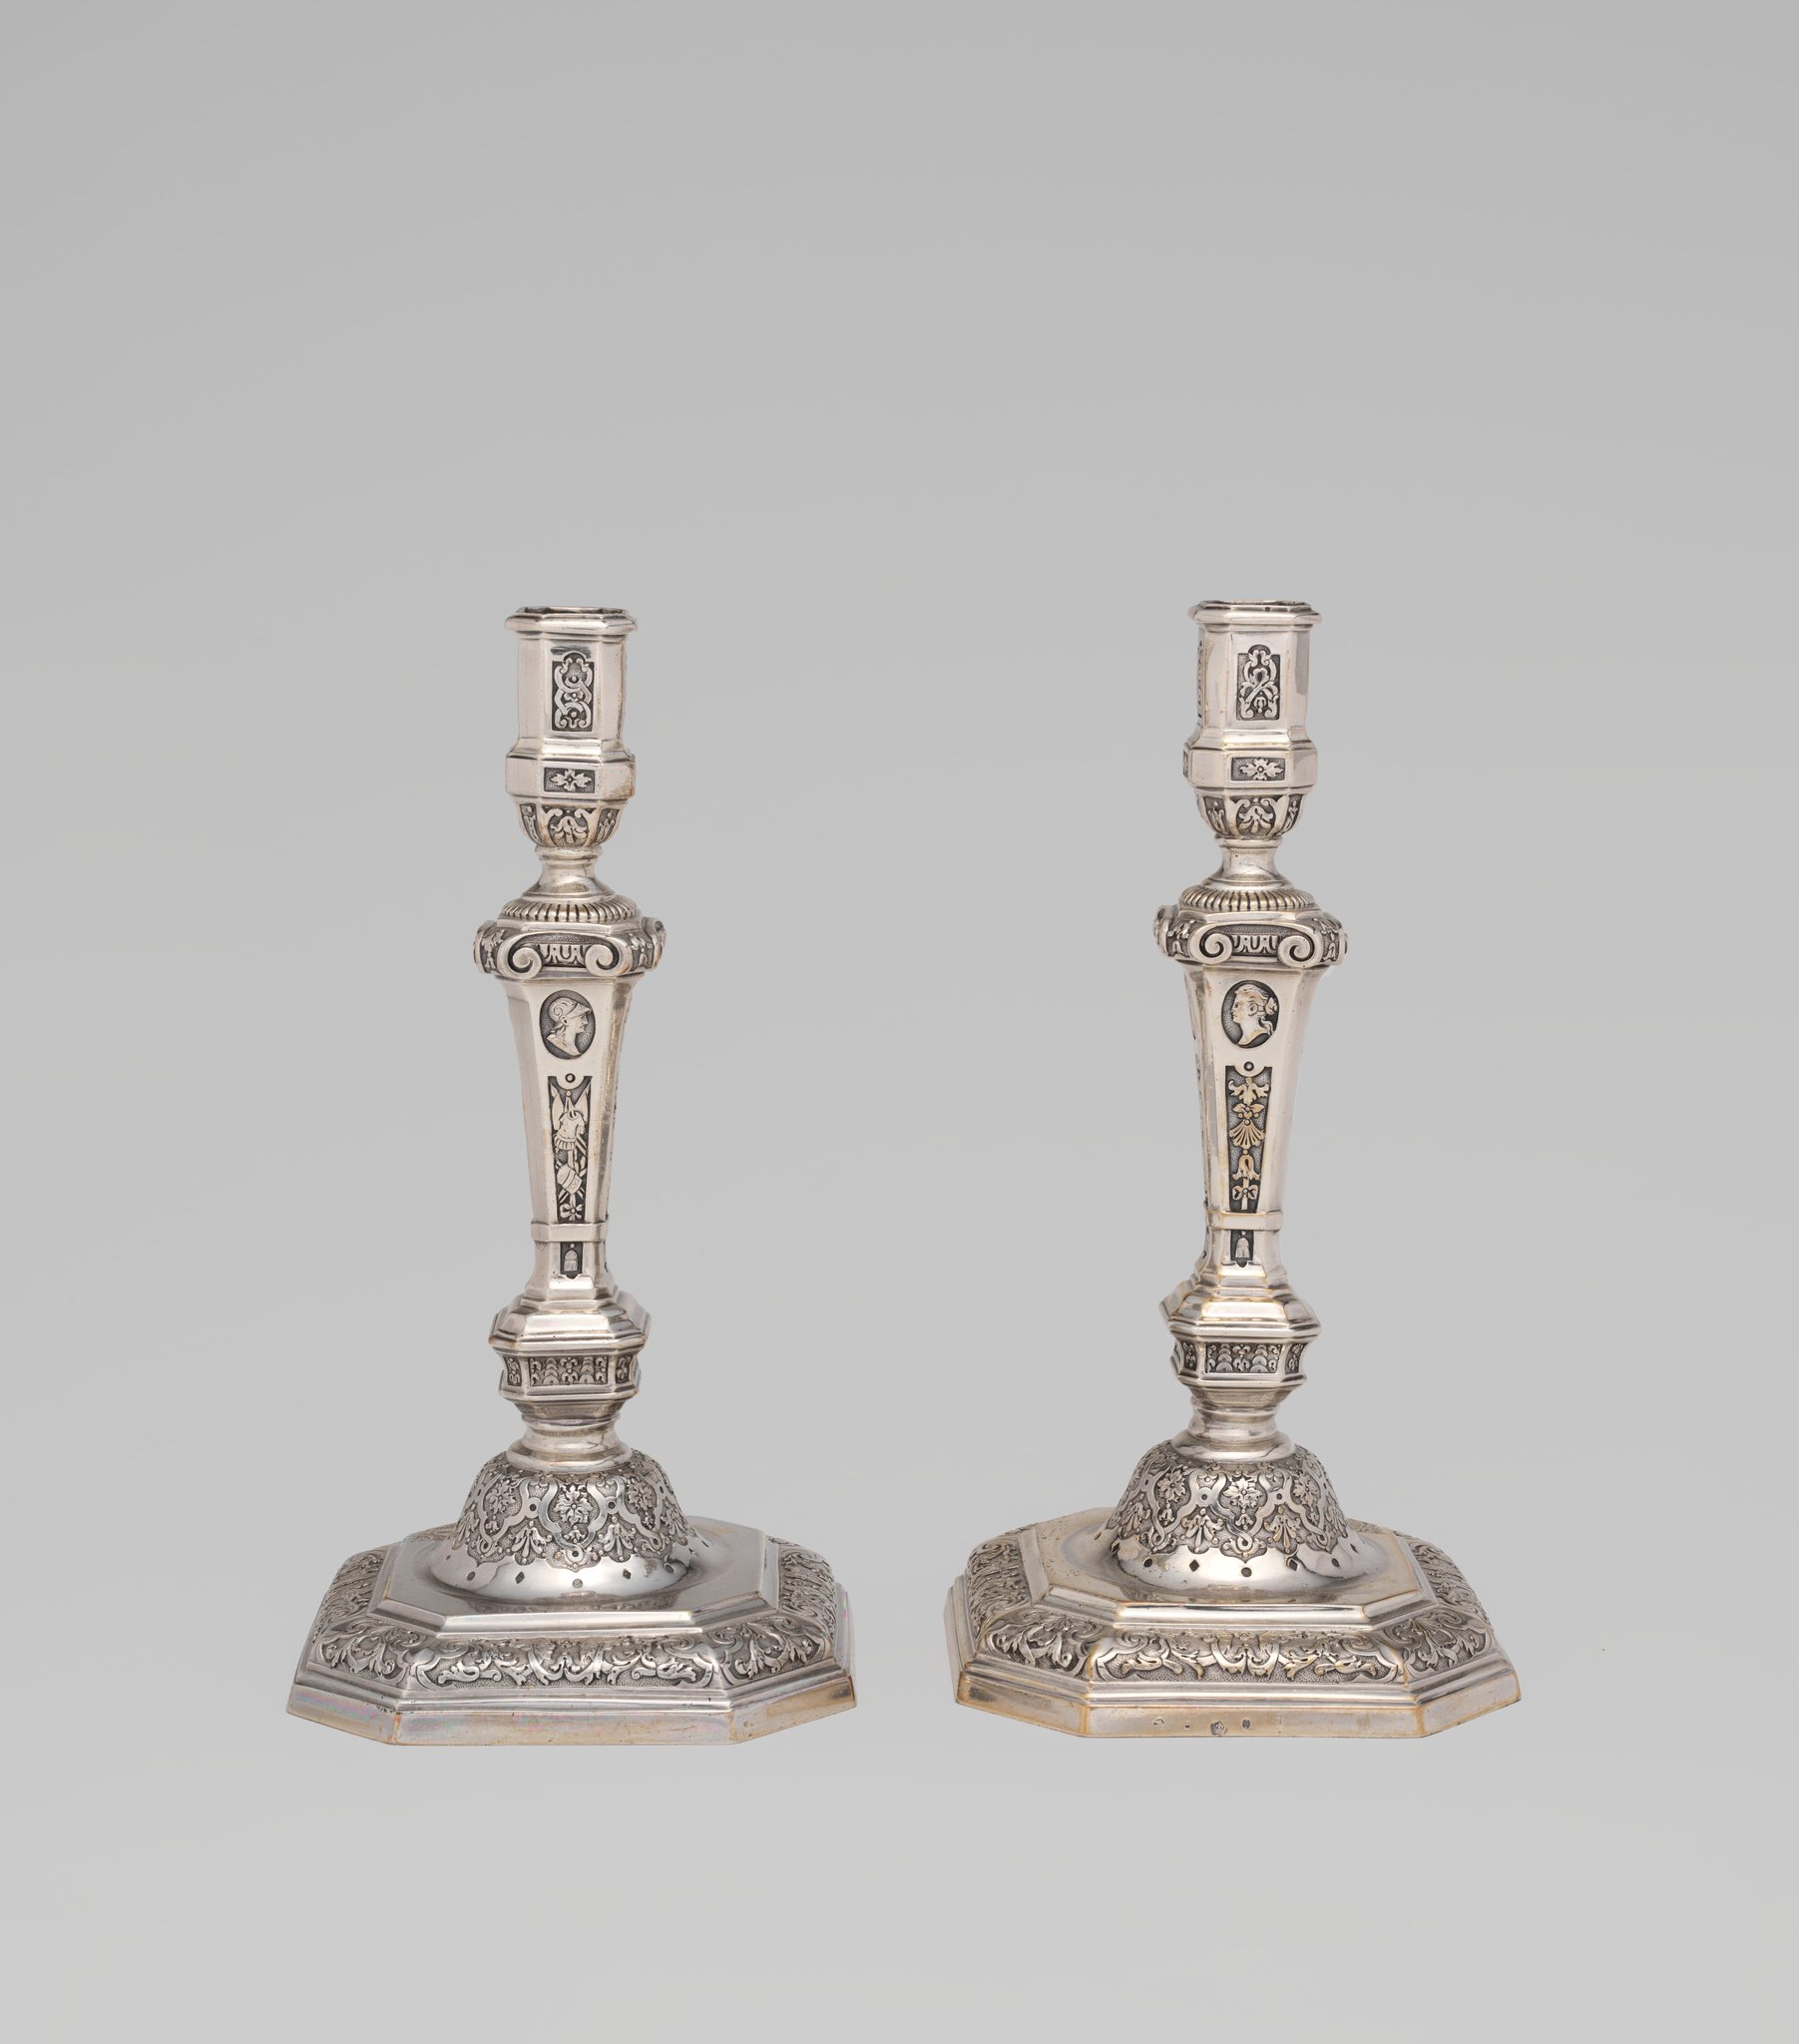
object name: candlestick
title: Pair of candlesticks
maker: jacques demé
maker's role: maker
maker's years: 1656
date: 1690-1691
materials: silver